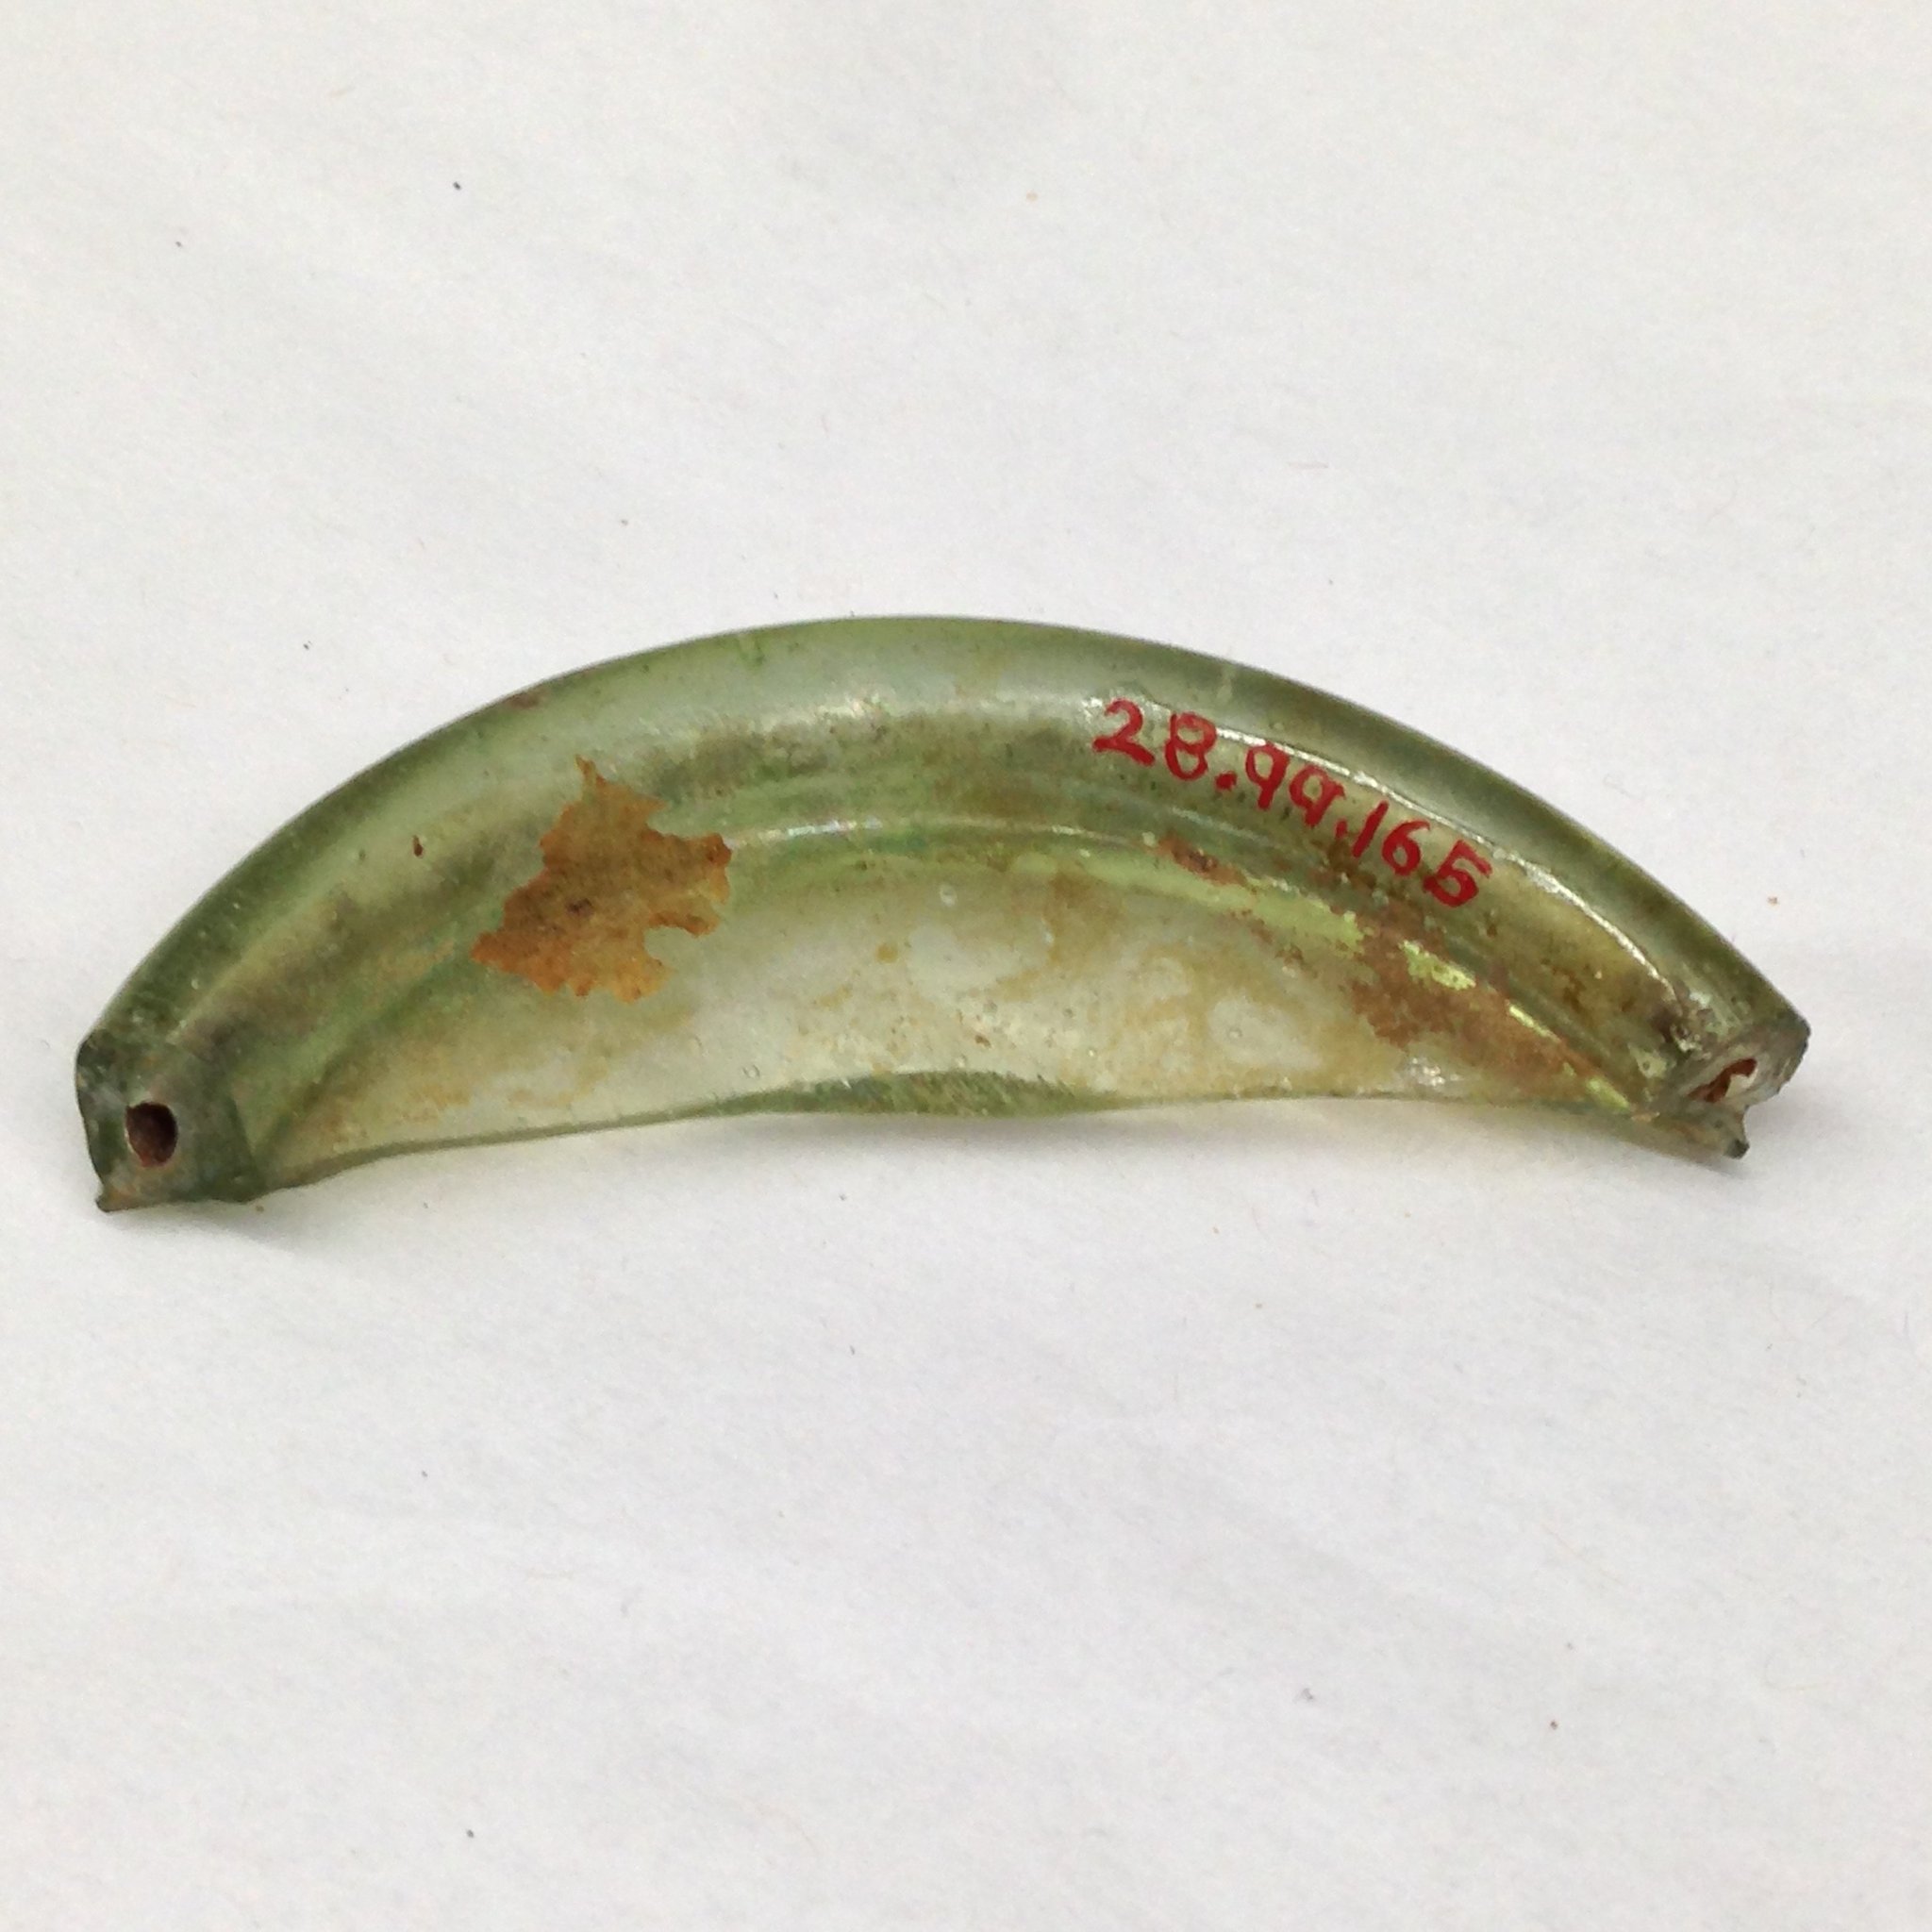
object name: fragment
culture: european or middle eastern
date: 1150-1250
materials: ceramic, glass